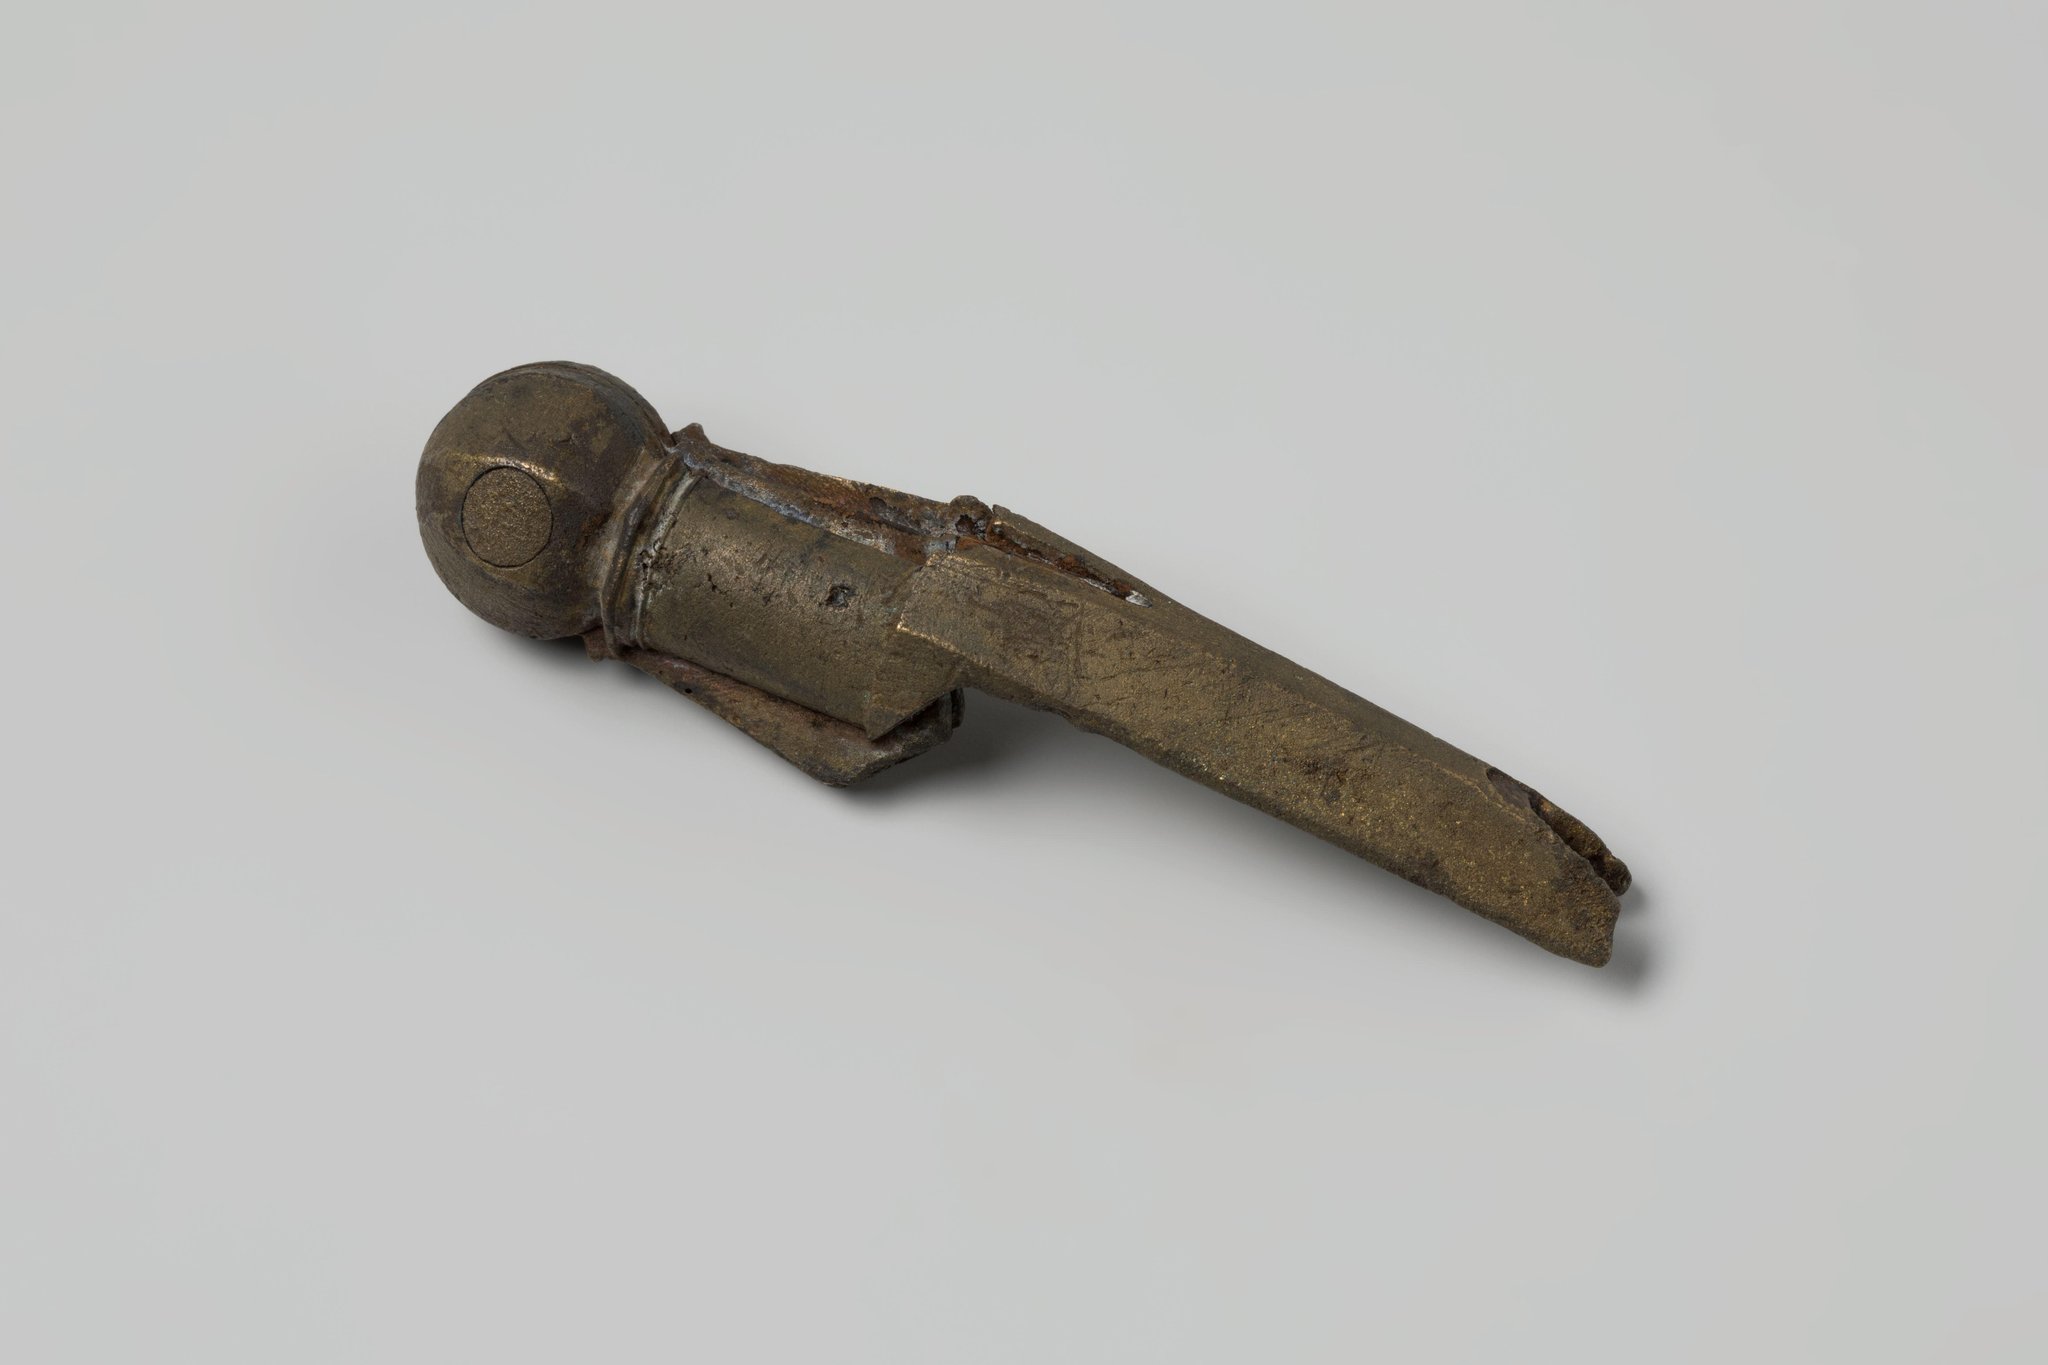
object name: divider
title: Steekpasser uit het wrak van de Oost-Indiëvaarder Hollandia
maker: Anonymous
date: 1700-1743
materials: copper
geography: netherlands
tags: verenigde oostindische compagnie, hollandia (schip), annet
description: Divider; fragment, leg: exterior three-faceted, bifid end with knob-shaped hinge, double bladed end of opposite leg in situ, broken off.